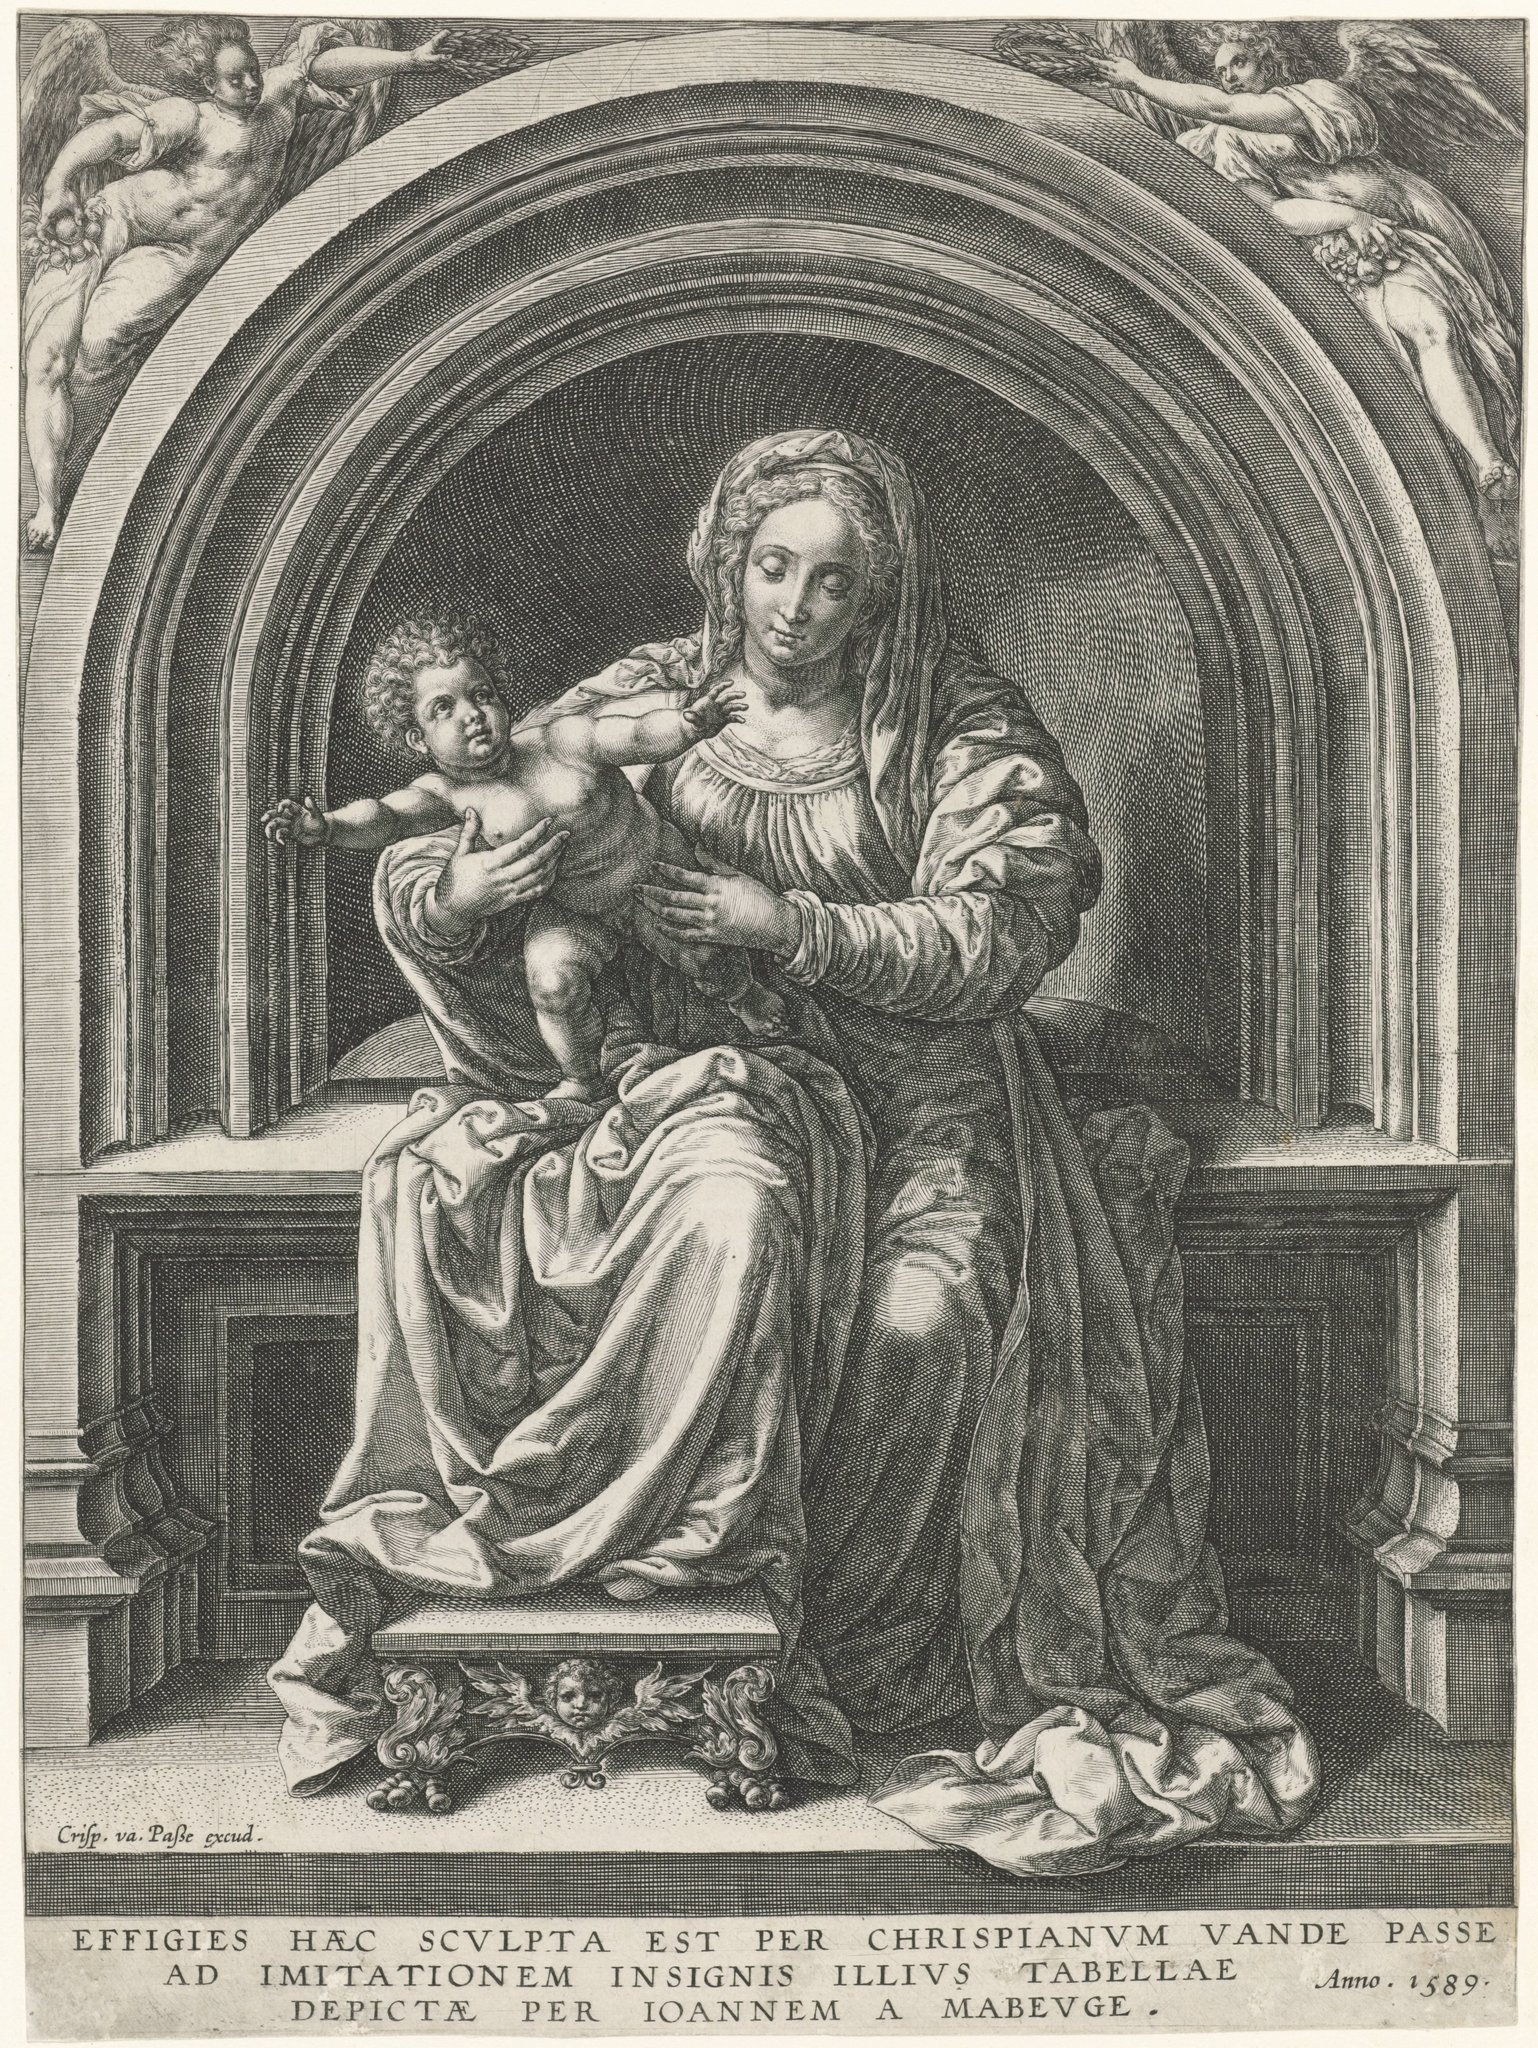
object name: print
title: Maria met het Christuskind op troon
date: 1589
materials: paper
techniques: engraving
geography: aachen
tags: madonna: mary sitting or enthroned, the christ-child in her lap (or in front of her bosom) (mary sometimes represented half-length), crowning with laurel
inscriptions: watermark, collector's mark: Lugt 240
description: Maria zit voor een boogvormige nis op een troon met het Christuskind op schoot. In de bovenhoeken engelen met een lauwerkrans. In de marge een drieregelig onderschrift in het Latijn.